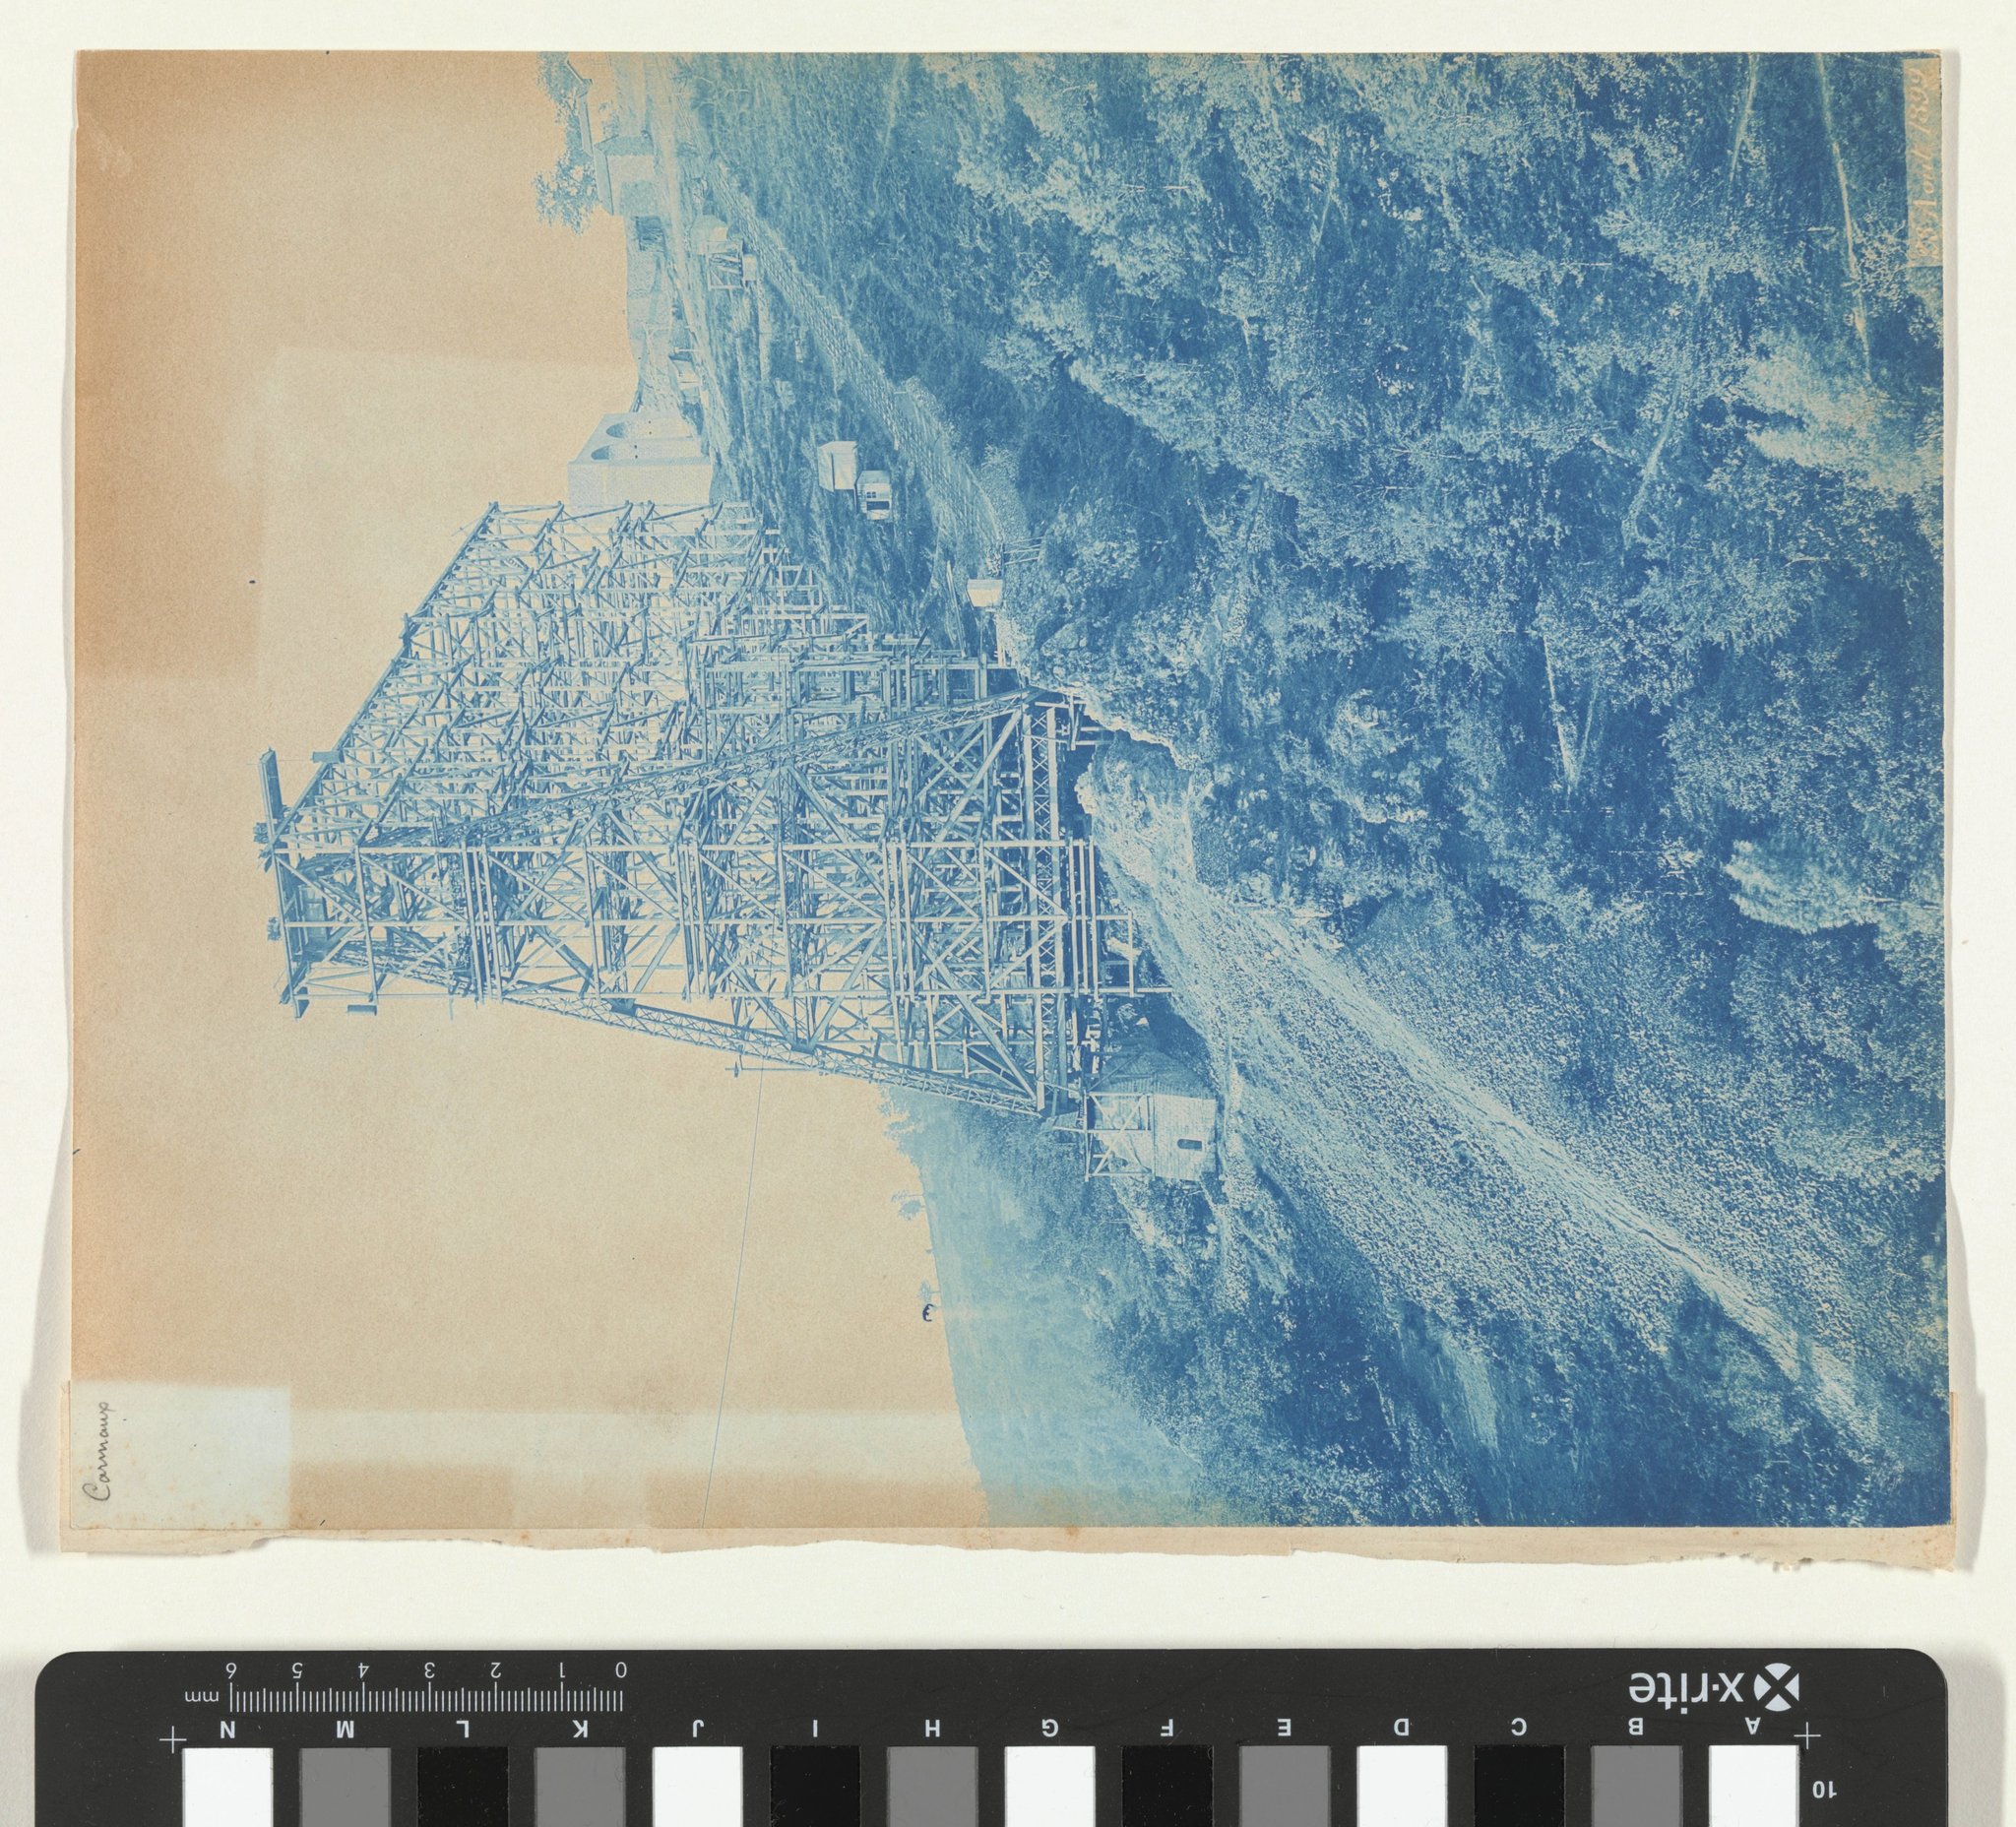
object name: photograph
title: Aanleg van het Viaur Viaduct in Frankrijk door de Societé de Construction des Battignolles, 28 (?) oktober 1899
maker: Anonymous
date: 1899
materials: photographic support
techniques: cyanotype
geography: france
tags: viaduct, making the overground structures (~ building activities)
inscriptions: inscription: ‘Carmaux’